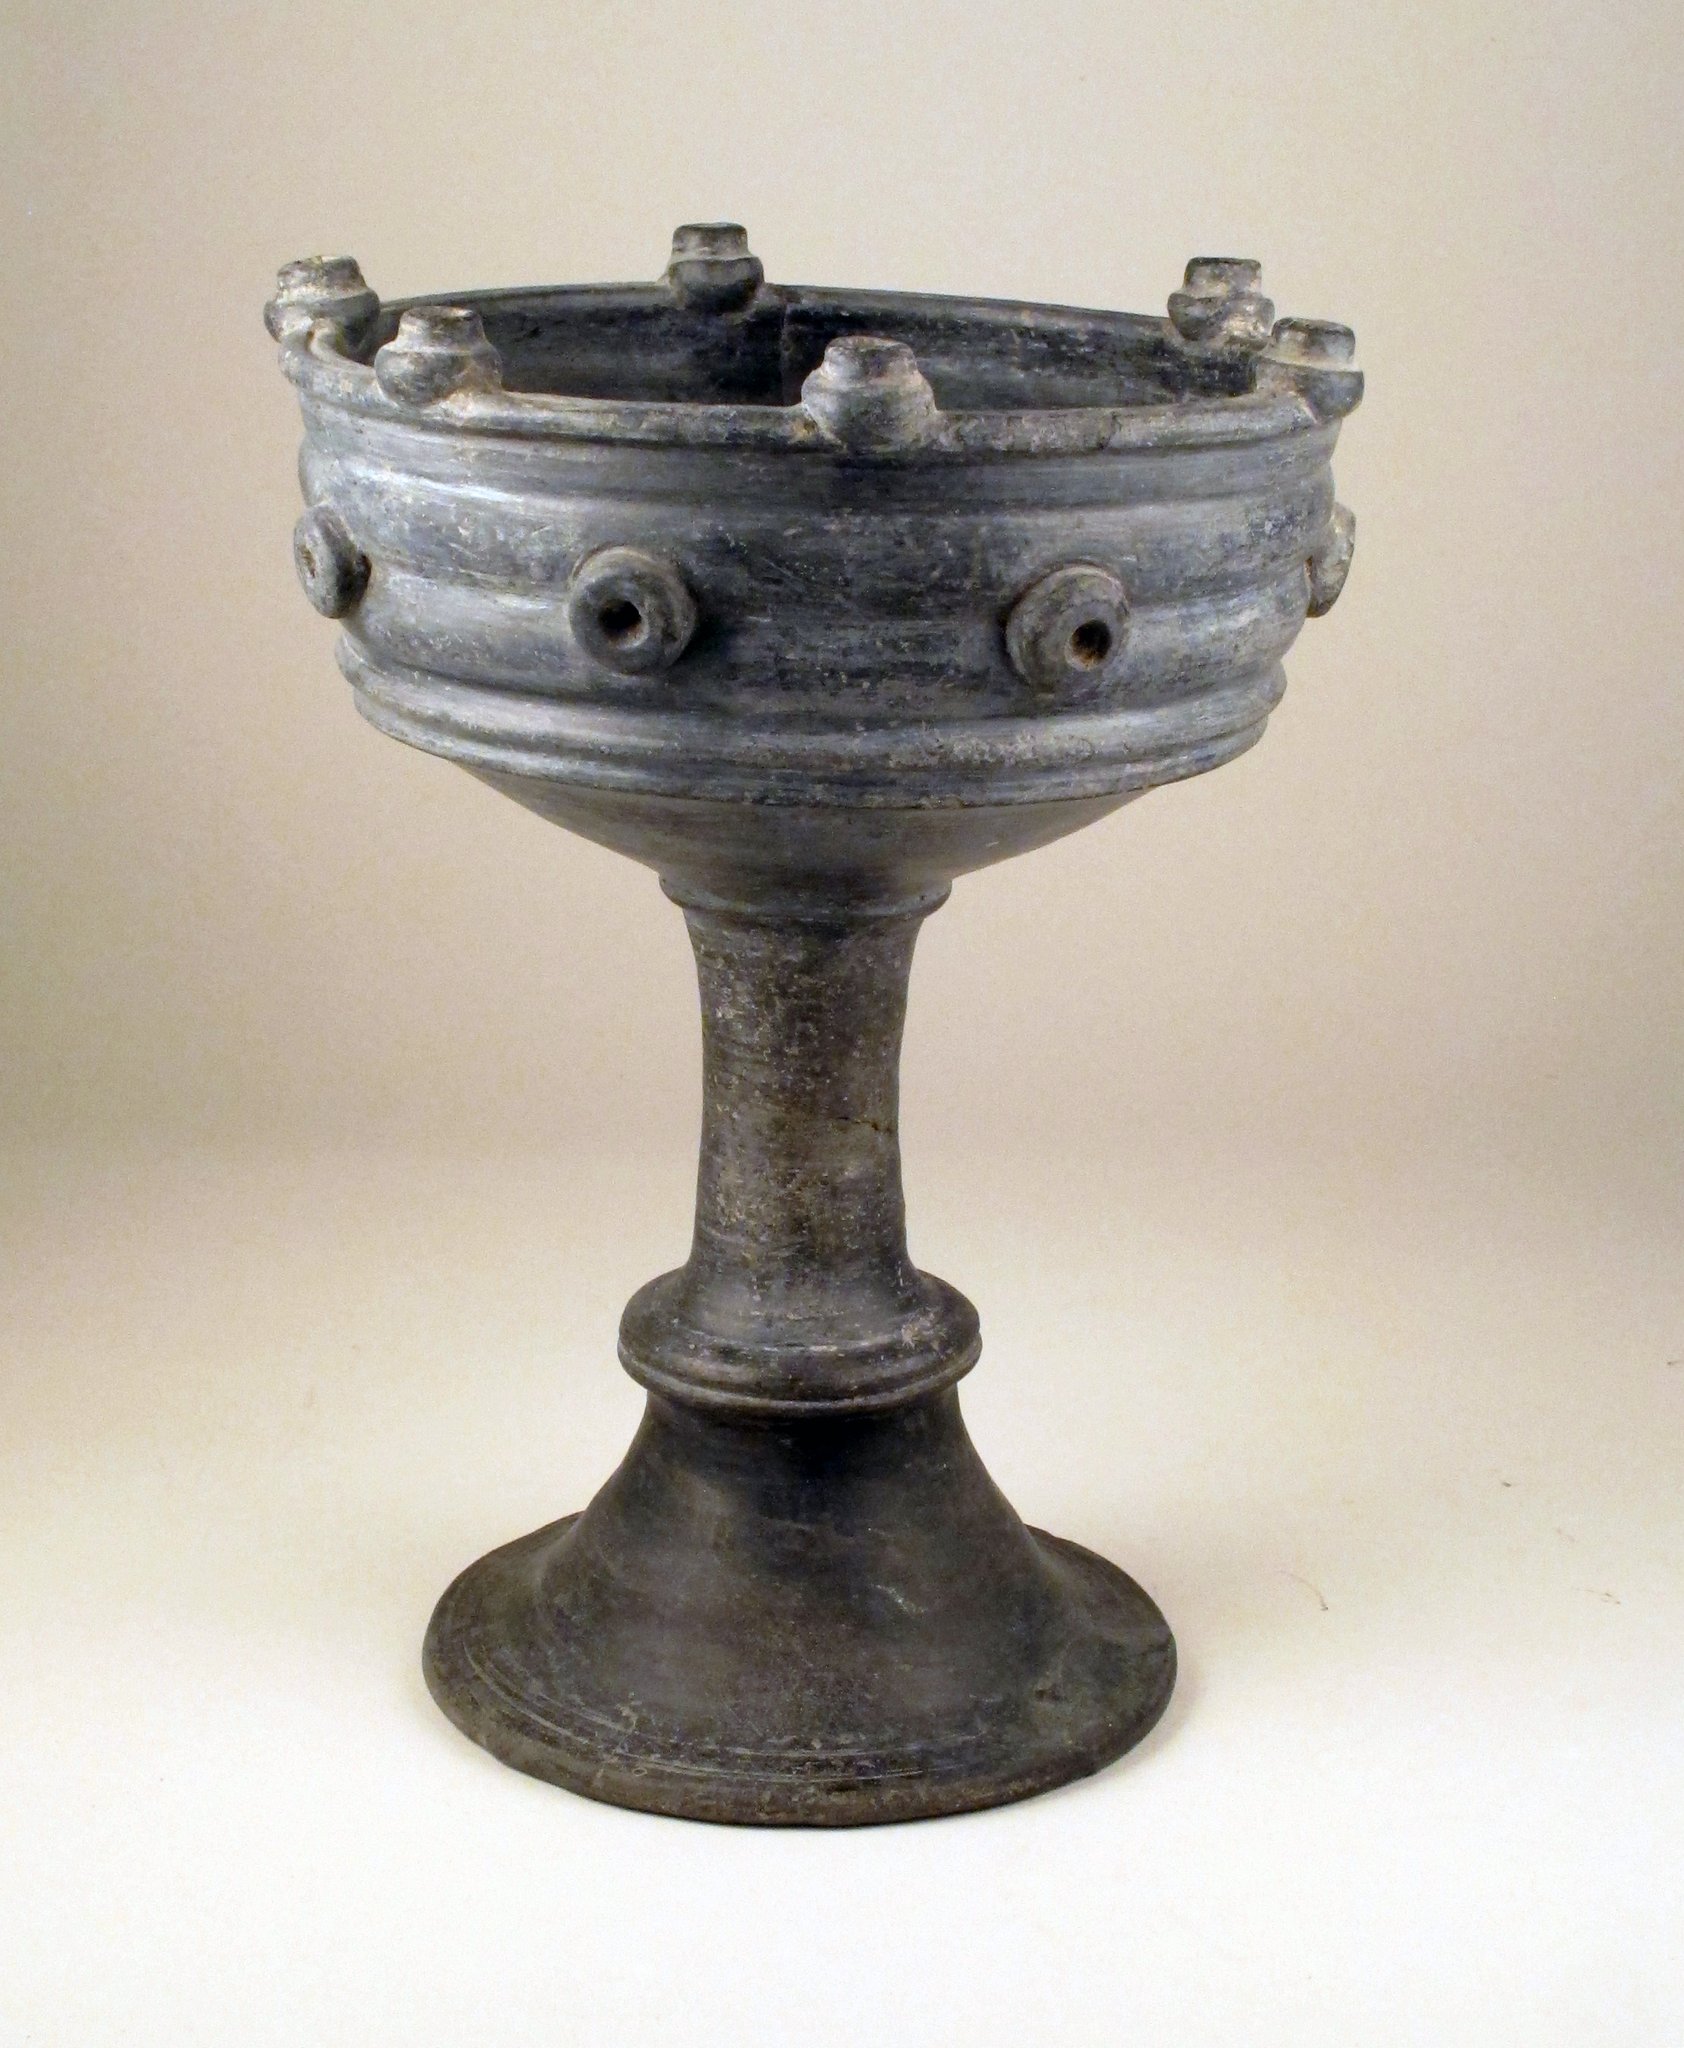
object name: cup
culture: etruscan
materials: terracotta